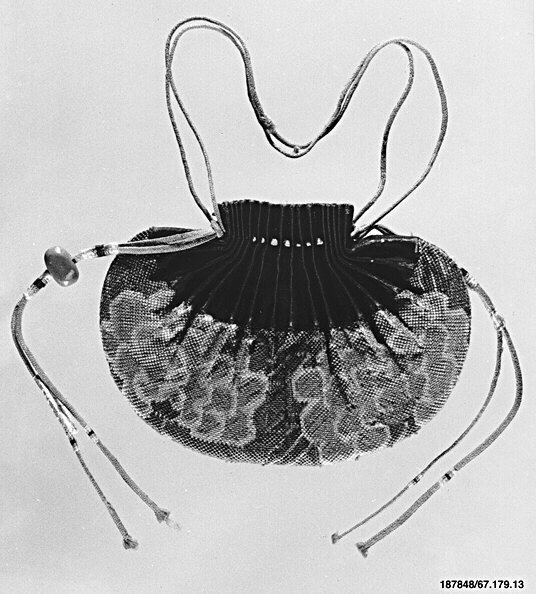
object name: purse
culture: chinese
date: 1801-1900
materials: silk